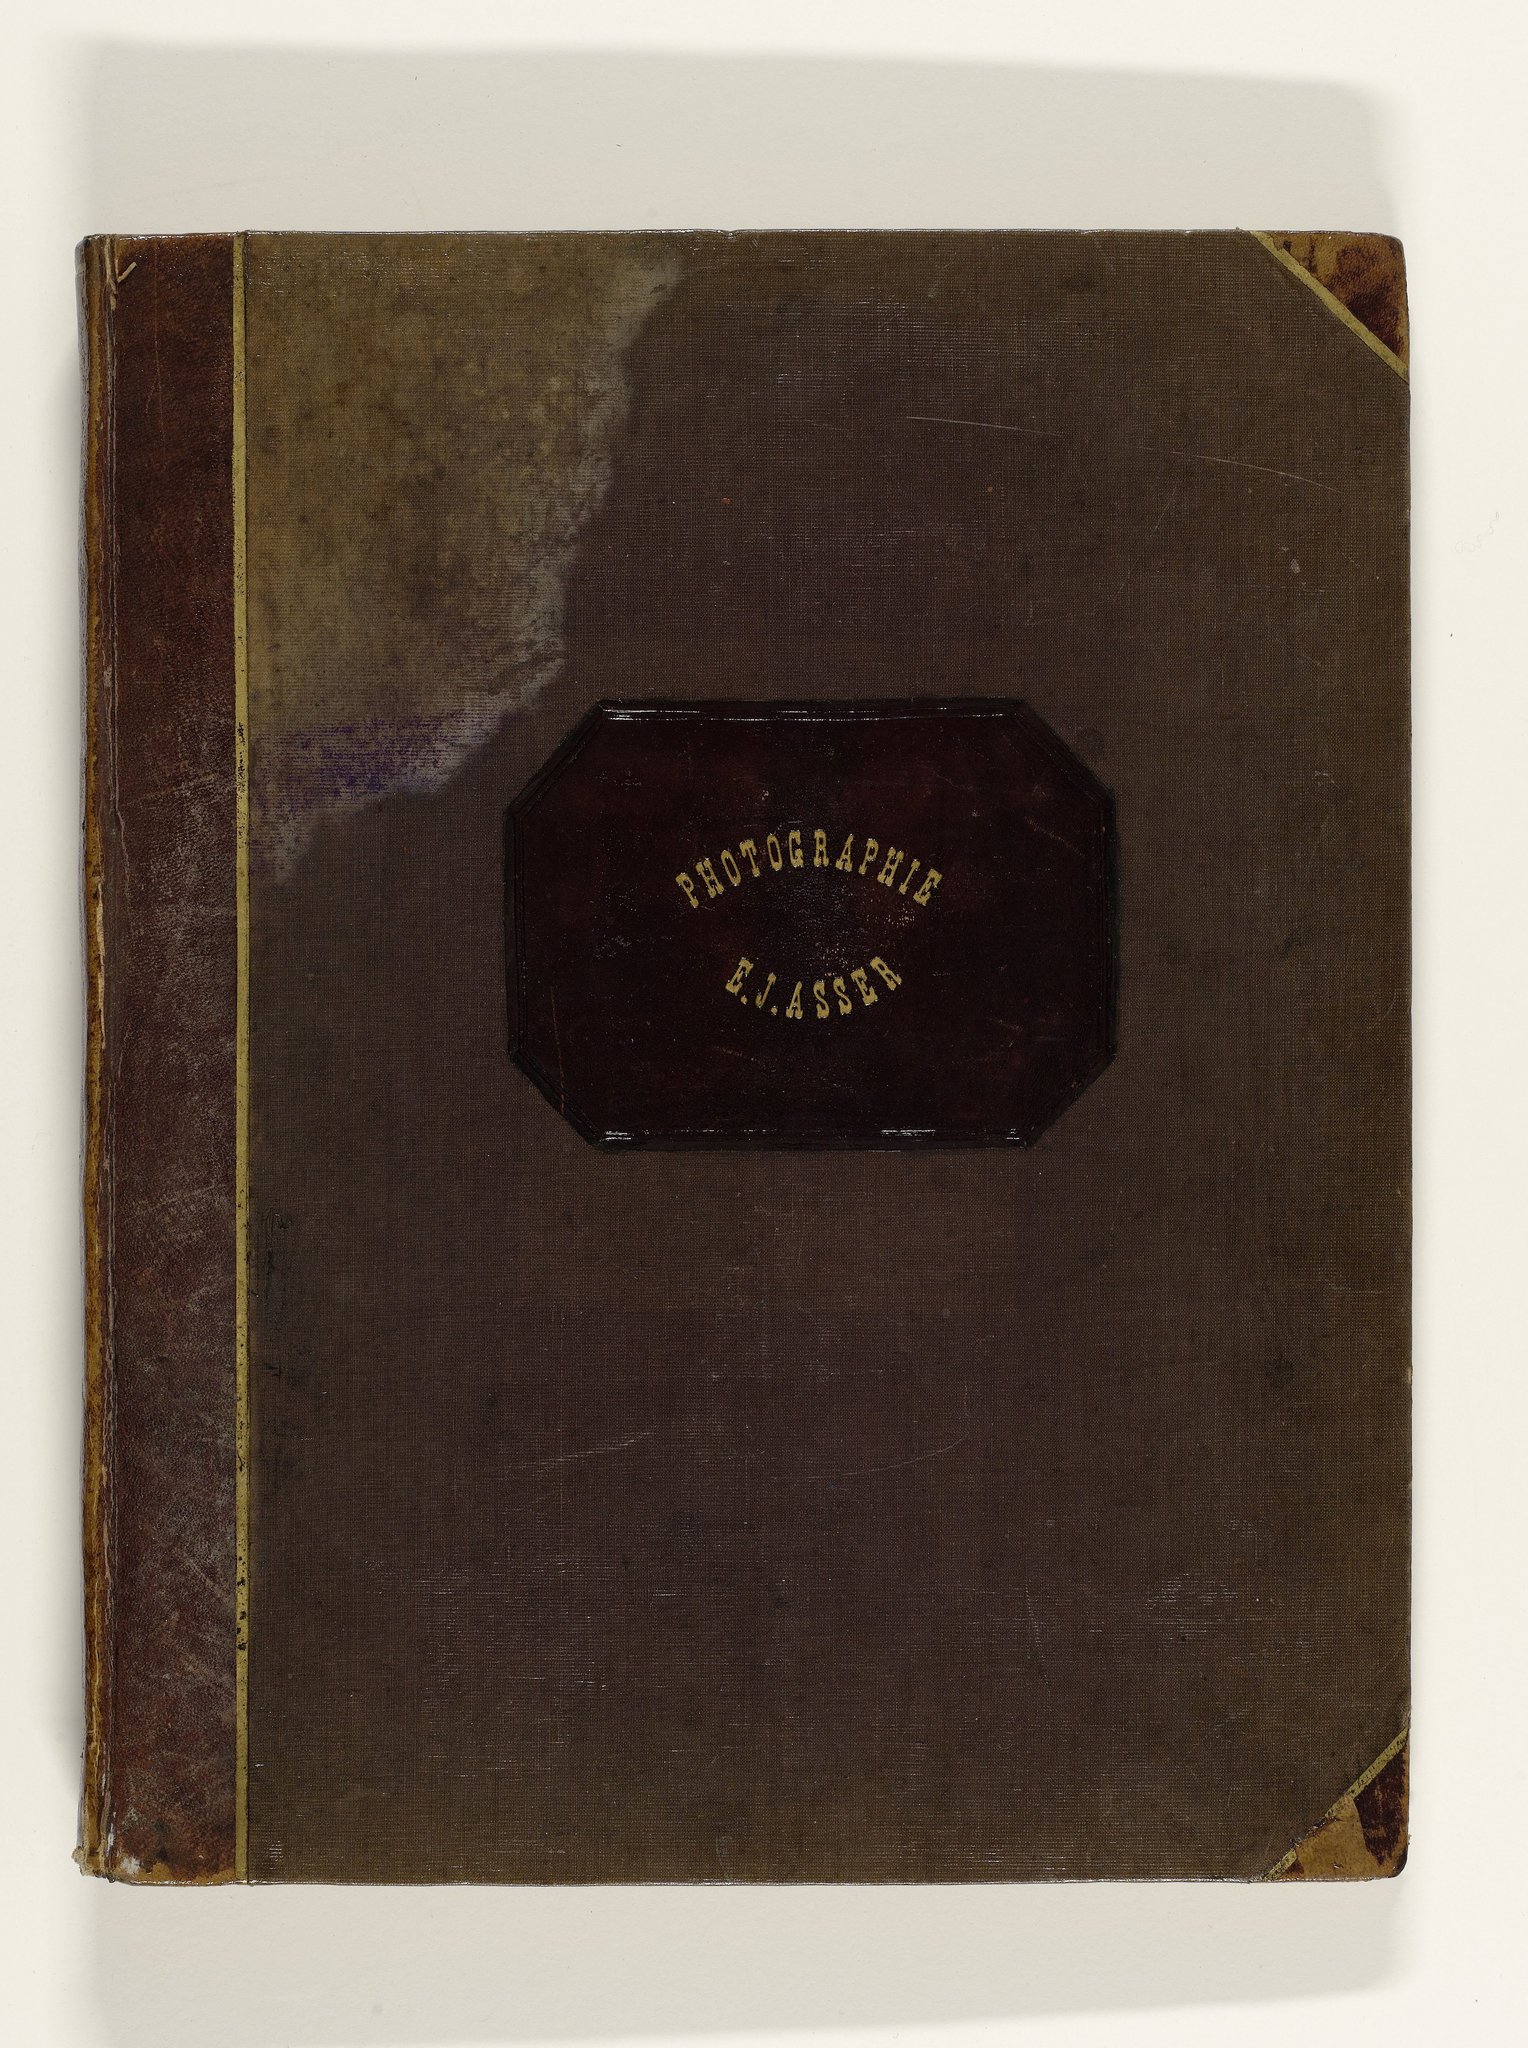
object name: photograph album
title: Album Photographie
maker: eduard isaac asser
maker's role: amateurfotograaf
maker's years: 1809-1894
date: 1856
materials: cardboard, leather, paper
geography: amsterdam